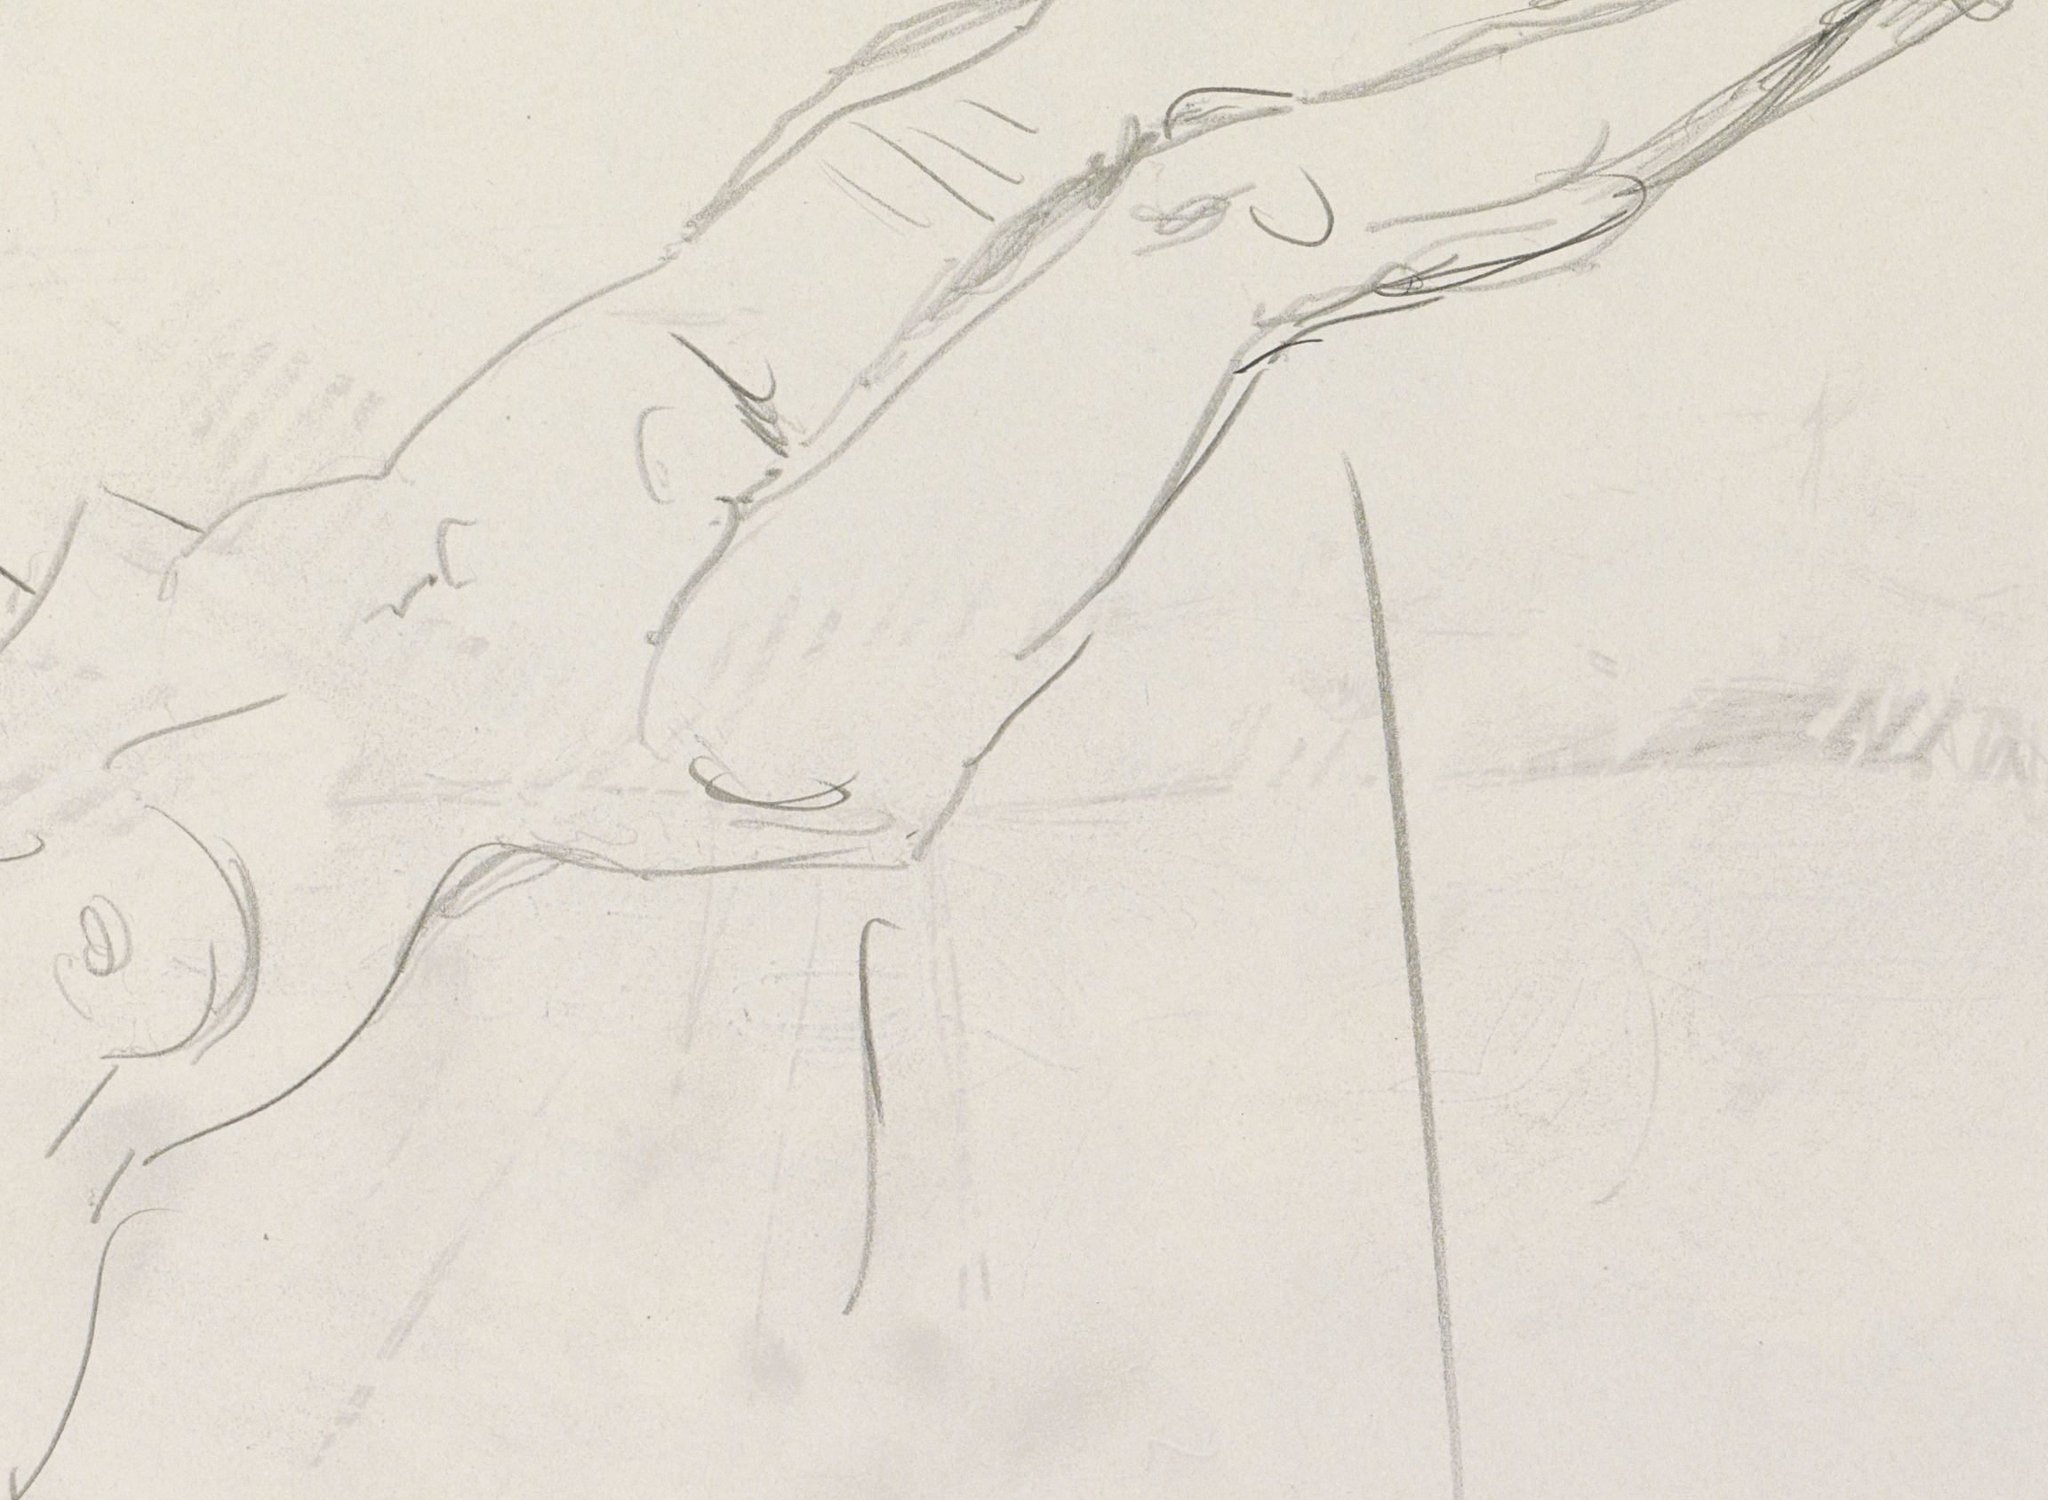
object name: sketchbook leaf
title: Vrouwelijk naakt op een bank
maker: isaac israels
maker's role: draughtsman, painter, print maker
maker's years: 1865-1934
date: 1915-1934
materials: paper, pencil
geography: the hague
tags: stretching (movement of the human body) - aa - female human figure, the (nude) human figure; 'corpo humano' (ripa) - aa - female human figure, couch, sofa, settee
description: Ze rekt zich mogelijk uit. Blad 13 verso uit schetsboek III met 36 bladen.